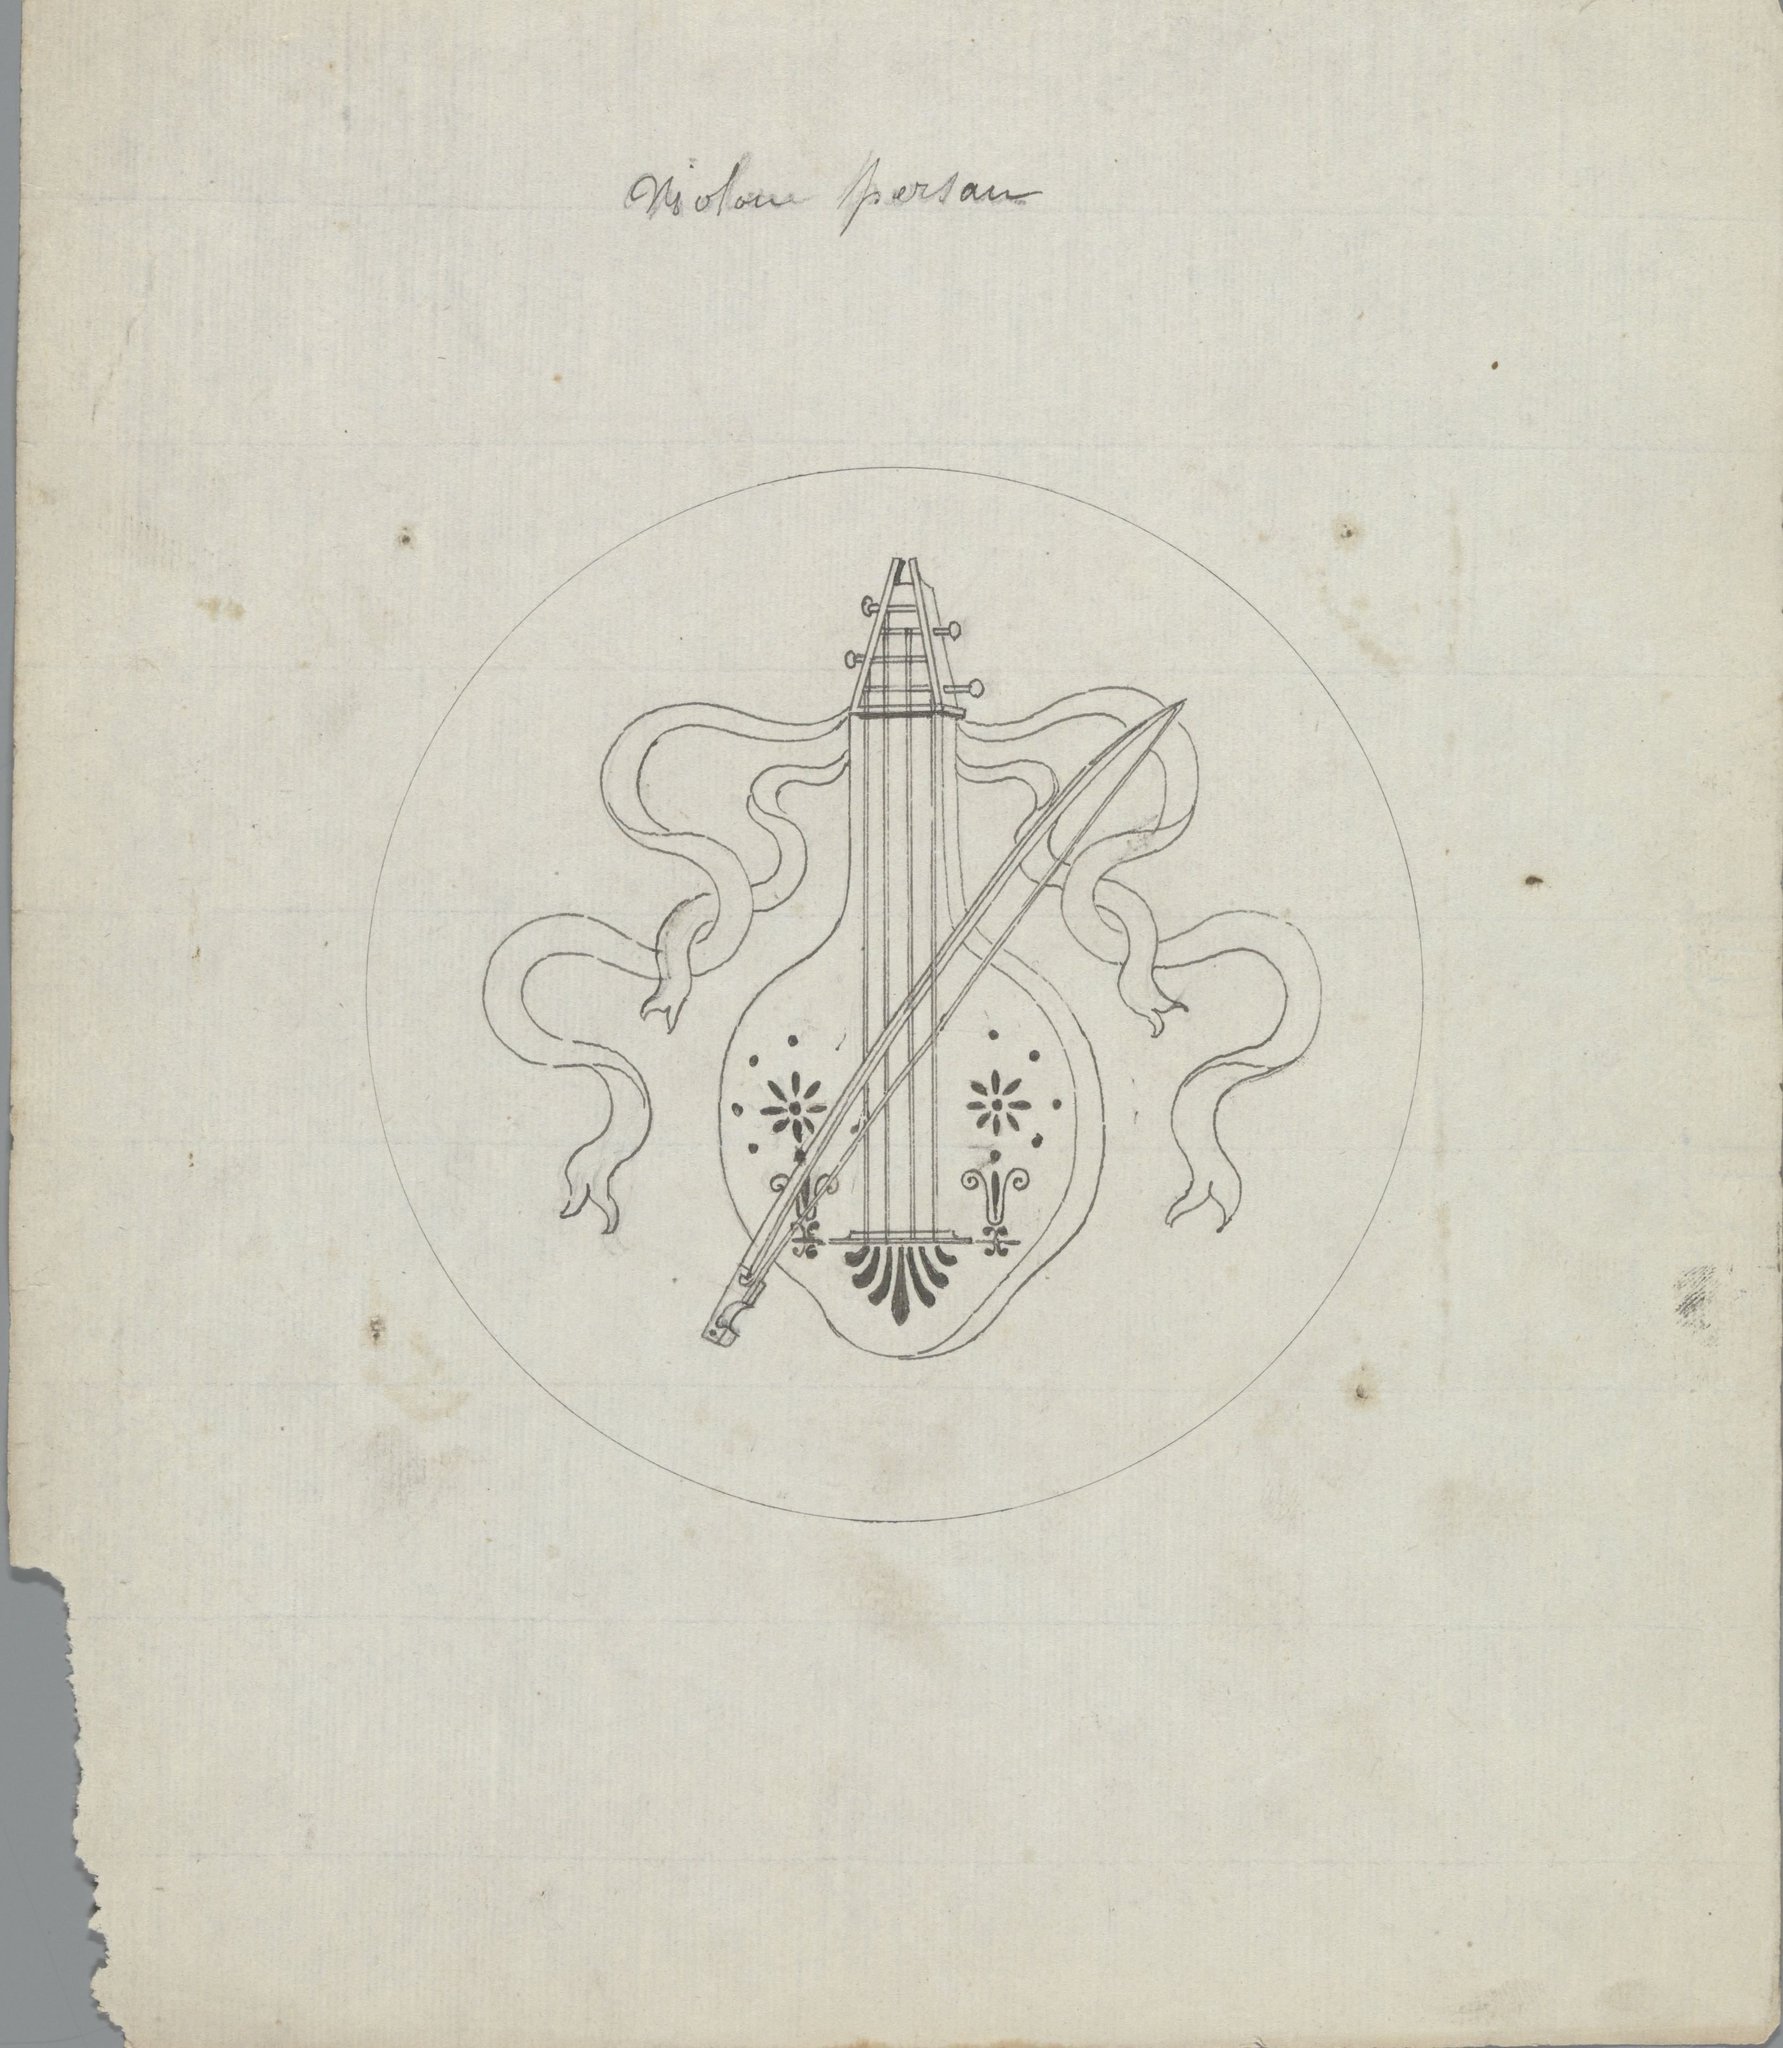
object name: design drawing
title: Ontwerp voor marqueterie van aan linten opgehangen muziekinstrument(en) in rond medaillon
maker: pierre félix van doren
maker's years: 1797-1856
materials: graphite, ink, paper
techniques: pen in black ink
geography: brussels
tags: trophy, i.e.: decorative arrangement of symbolic or typical objects ~ ornament, string instruments (bowed)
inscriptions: watermark: ‘V.D.L.’, inscription: ‘violon persan’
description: Een van 103 ontwerpen voor marqueterie van aan linten opgehangen muziekinstrumenten in ronde medaillons, bestemd voor de set stoelen gemaakt door Van Doren voor de grote zaal van het Paleis van de Prins van Oranje in Brussel in 1828.